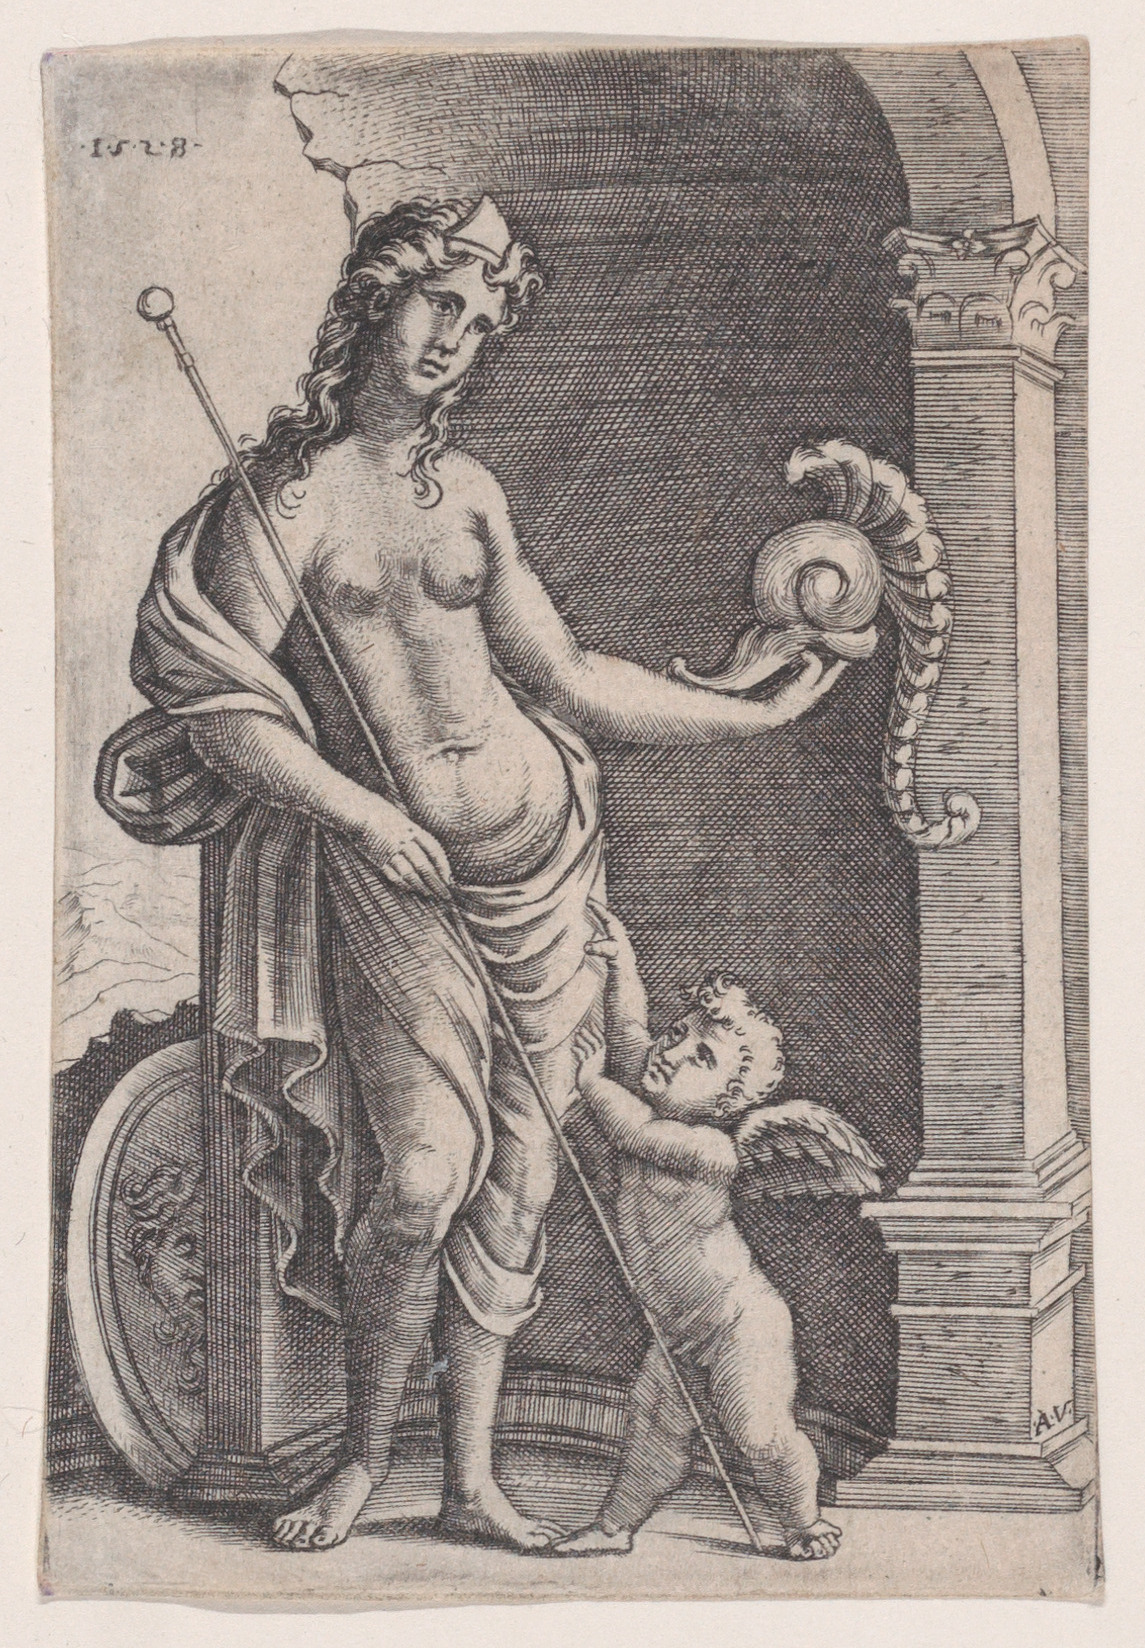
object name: print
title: The Love of Glory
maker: agostino veneziano (agostino dei musi)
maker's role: artist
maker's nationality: italian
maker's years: 1490-1536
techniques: engraving